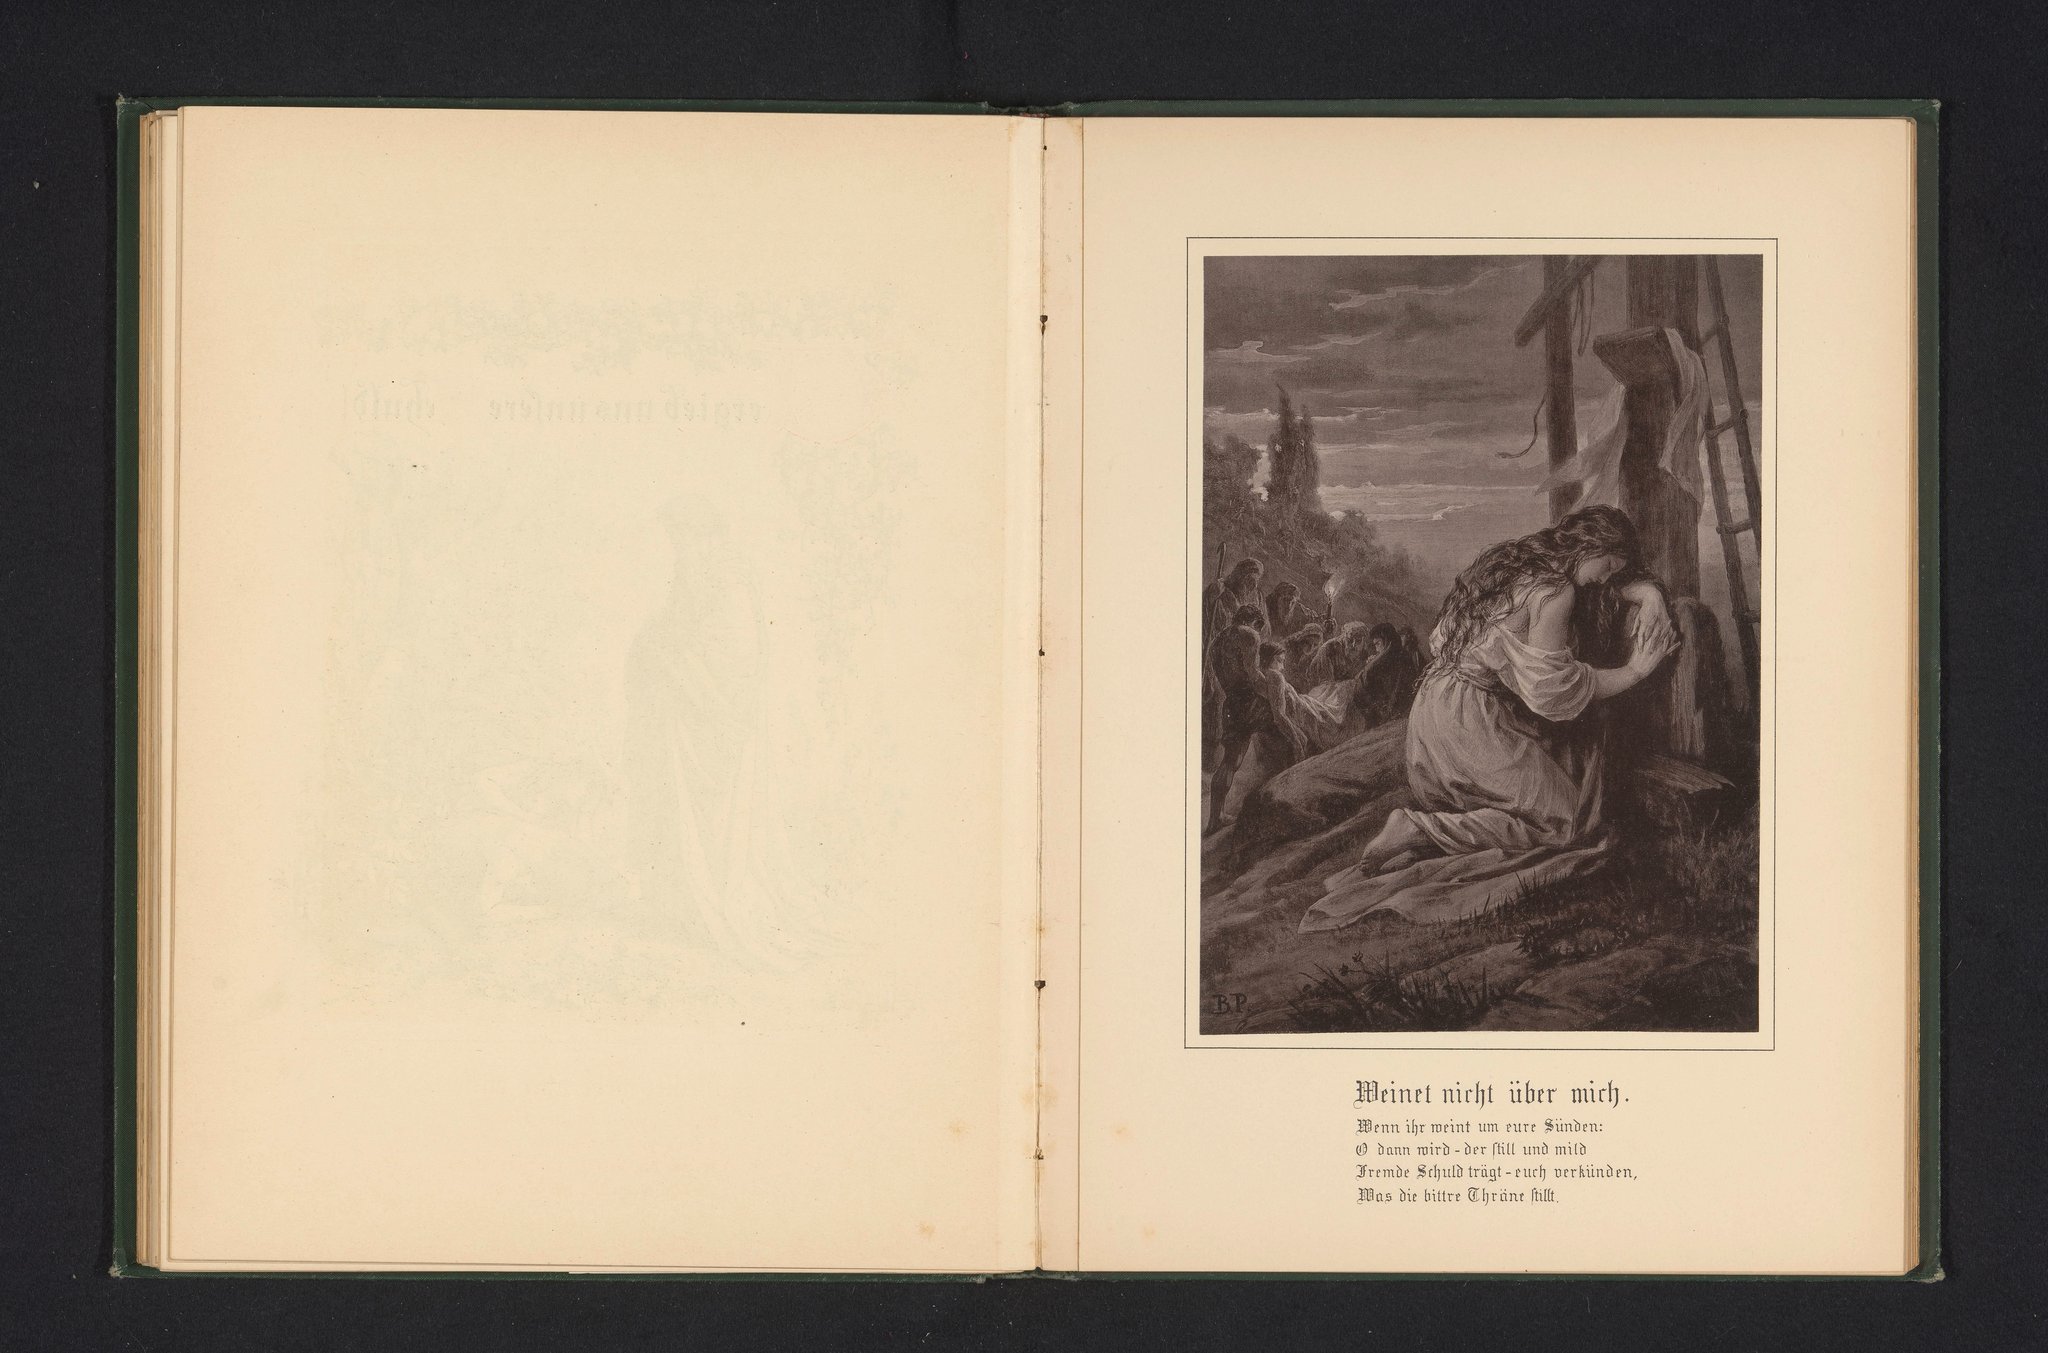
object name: page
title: Weinet nicht über mich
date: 1874-1884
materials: paper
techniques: photograph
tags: the cross ~ symbols of christ, weeping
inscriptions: inscription: ‘Wenn ihr weint um eure Sünden: O dann wird-der still und mild Fremde Schuld trägt - euch verkünden, Was die bittere Thräne Stillt’